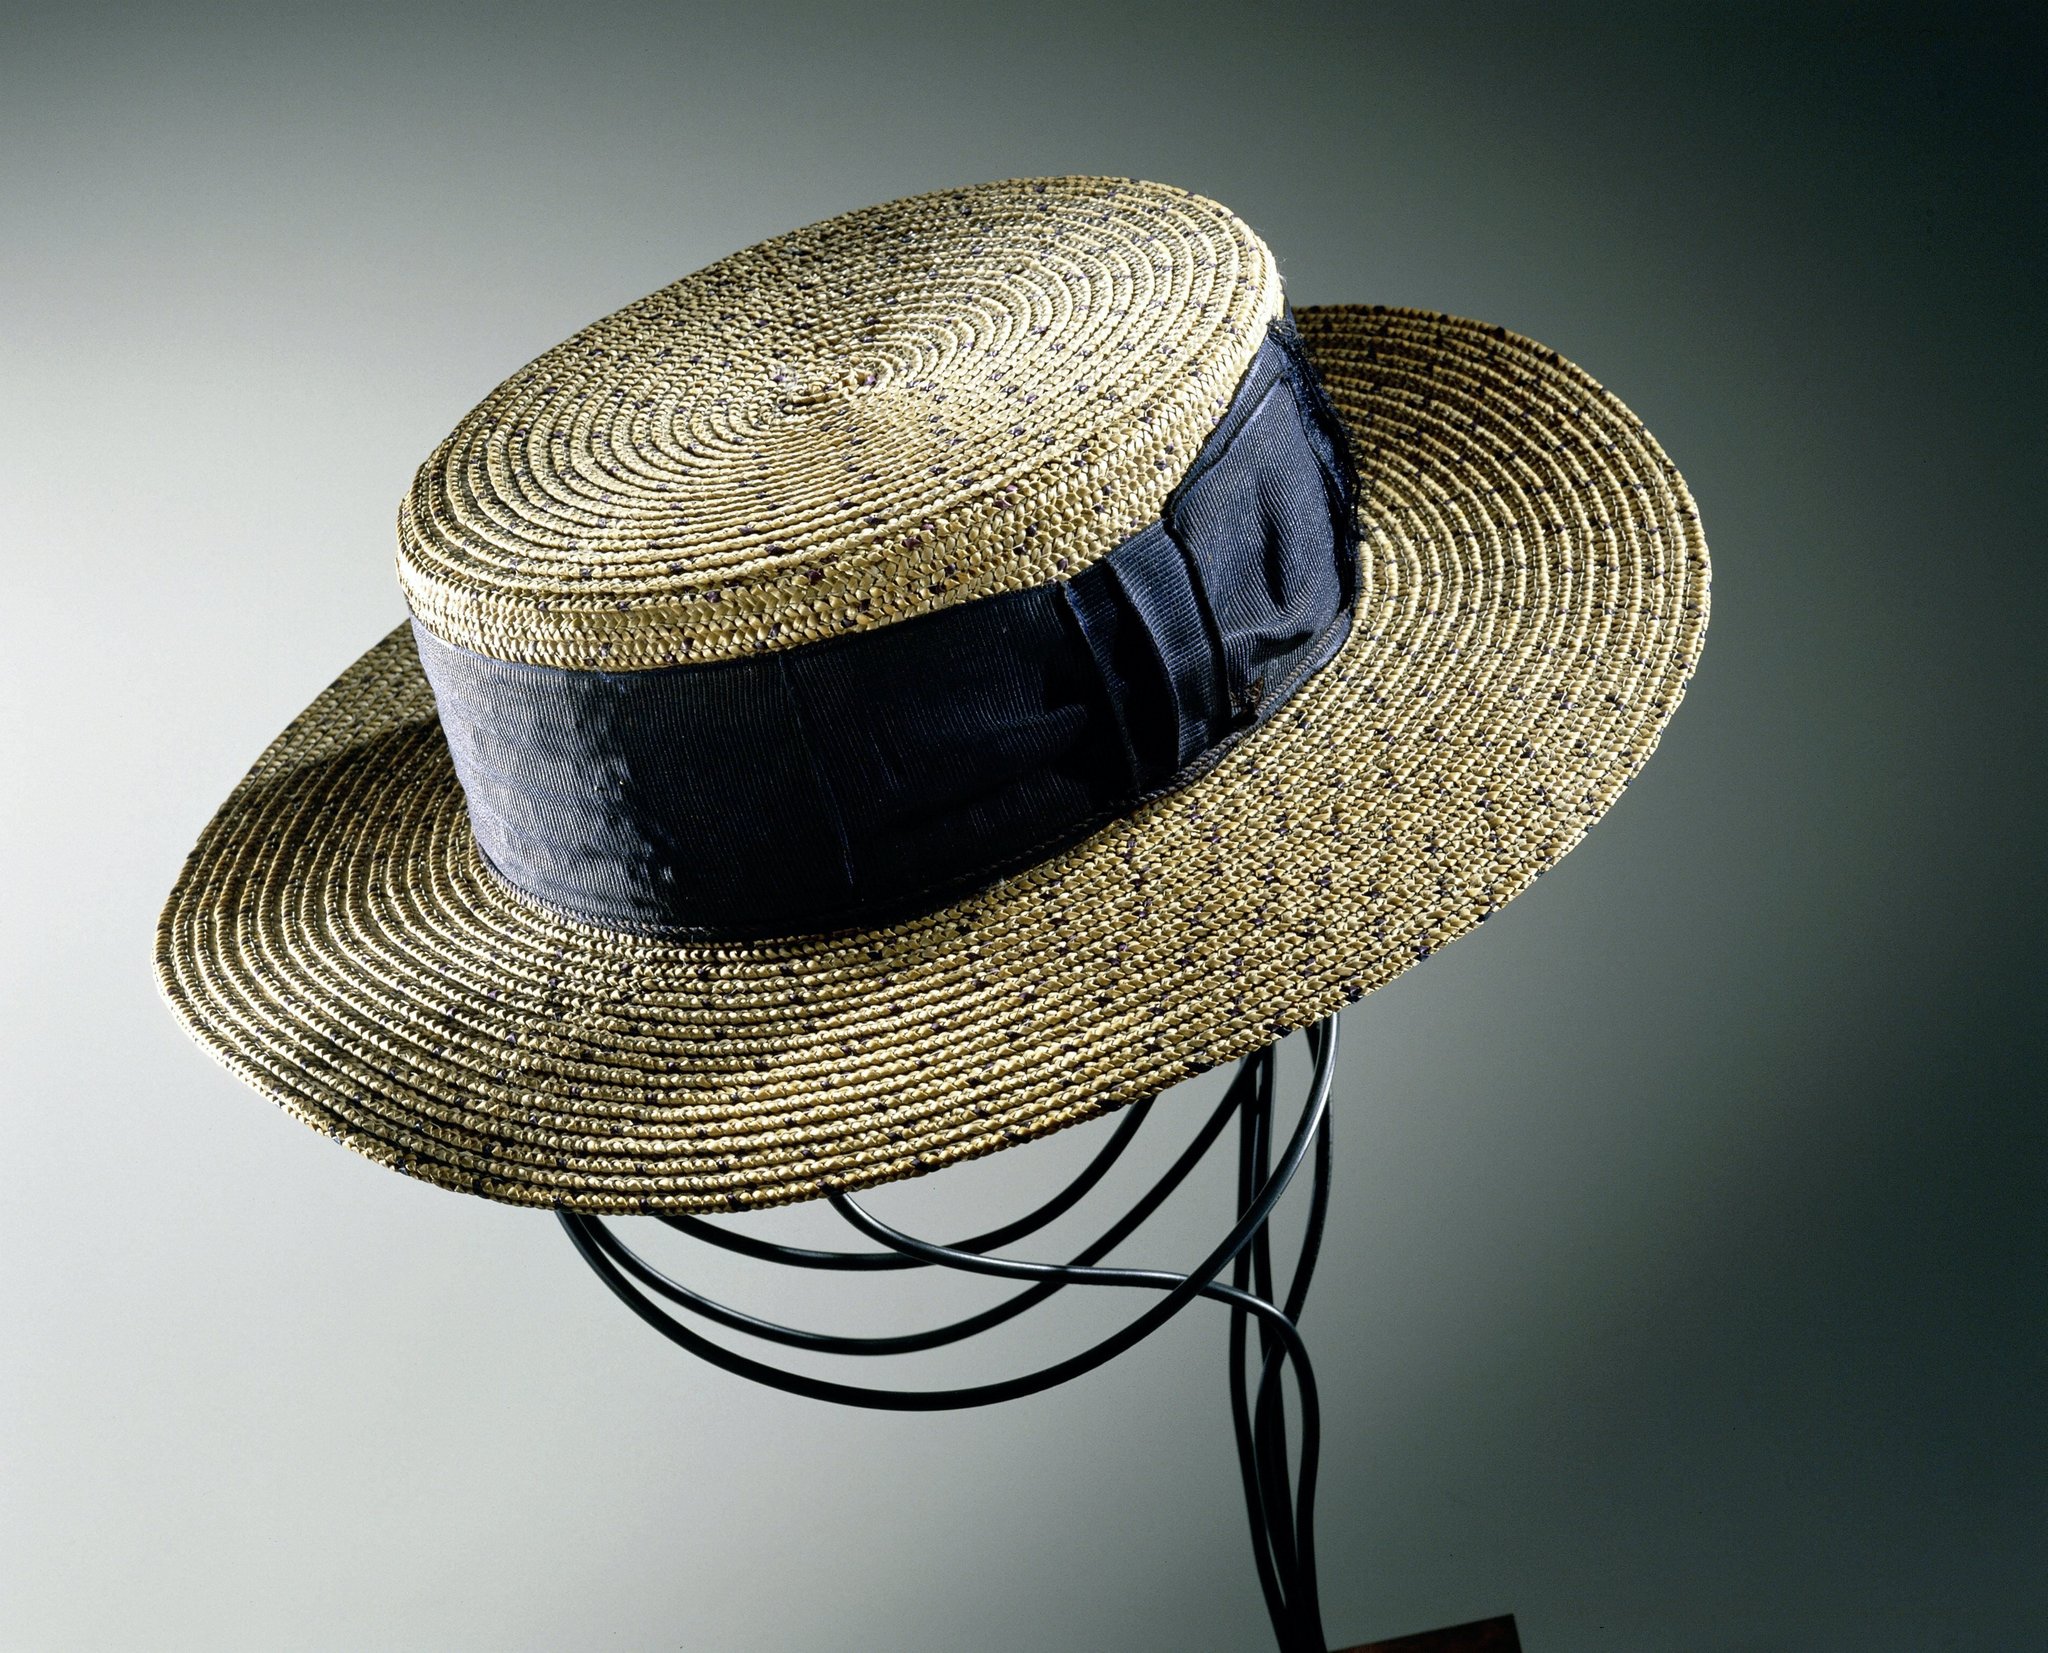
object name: straw hat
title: Straw boater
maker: Anonymous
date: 1900-1930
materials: silk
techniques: rib binding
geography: france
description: Strohoed, zogenaamde boater of canotier, van blauw gespikkeld, middelgrof en genaaid bandstro, met donkerblauw ripslint. Laag, ovaal, plat. Beige leren entrée. Capeline van witte ripszijde met plisserstrook op de bodem, gazen opstand. Met entree van leer waarin een blindgestempeld motief.